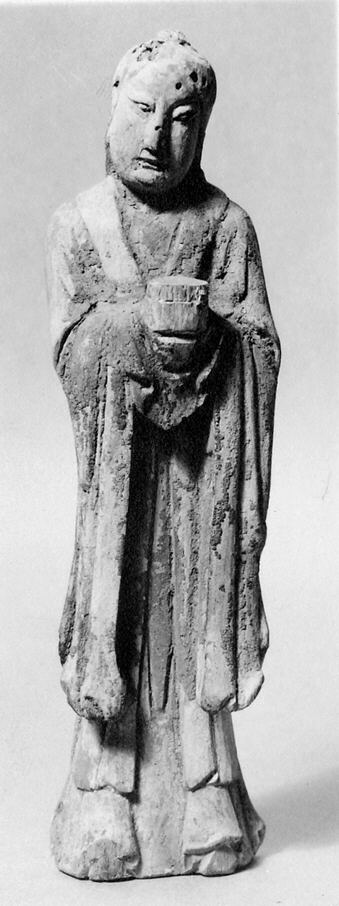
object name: figure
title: Statuette of Buddhist Disciple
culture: chinese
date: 960-1279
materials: wood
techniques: polychrome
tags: men,buddhism